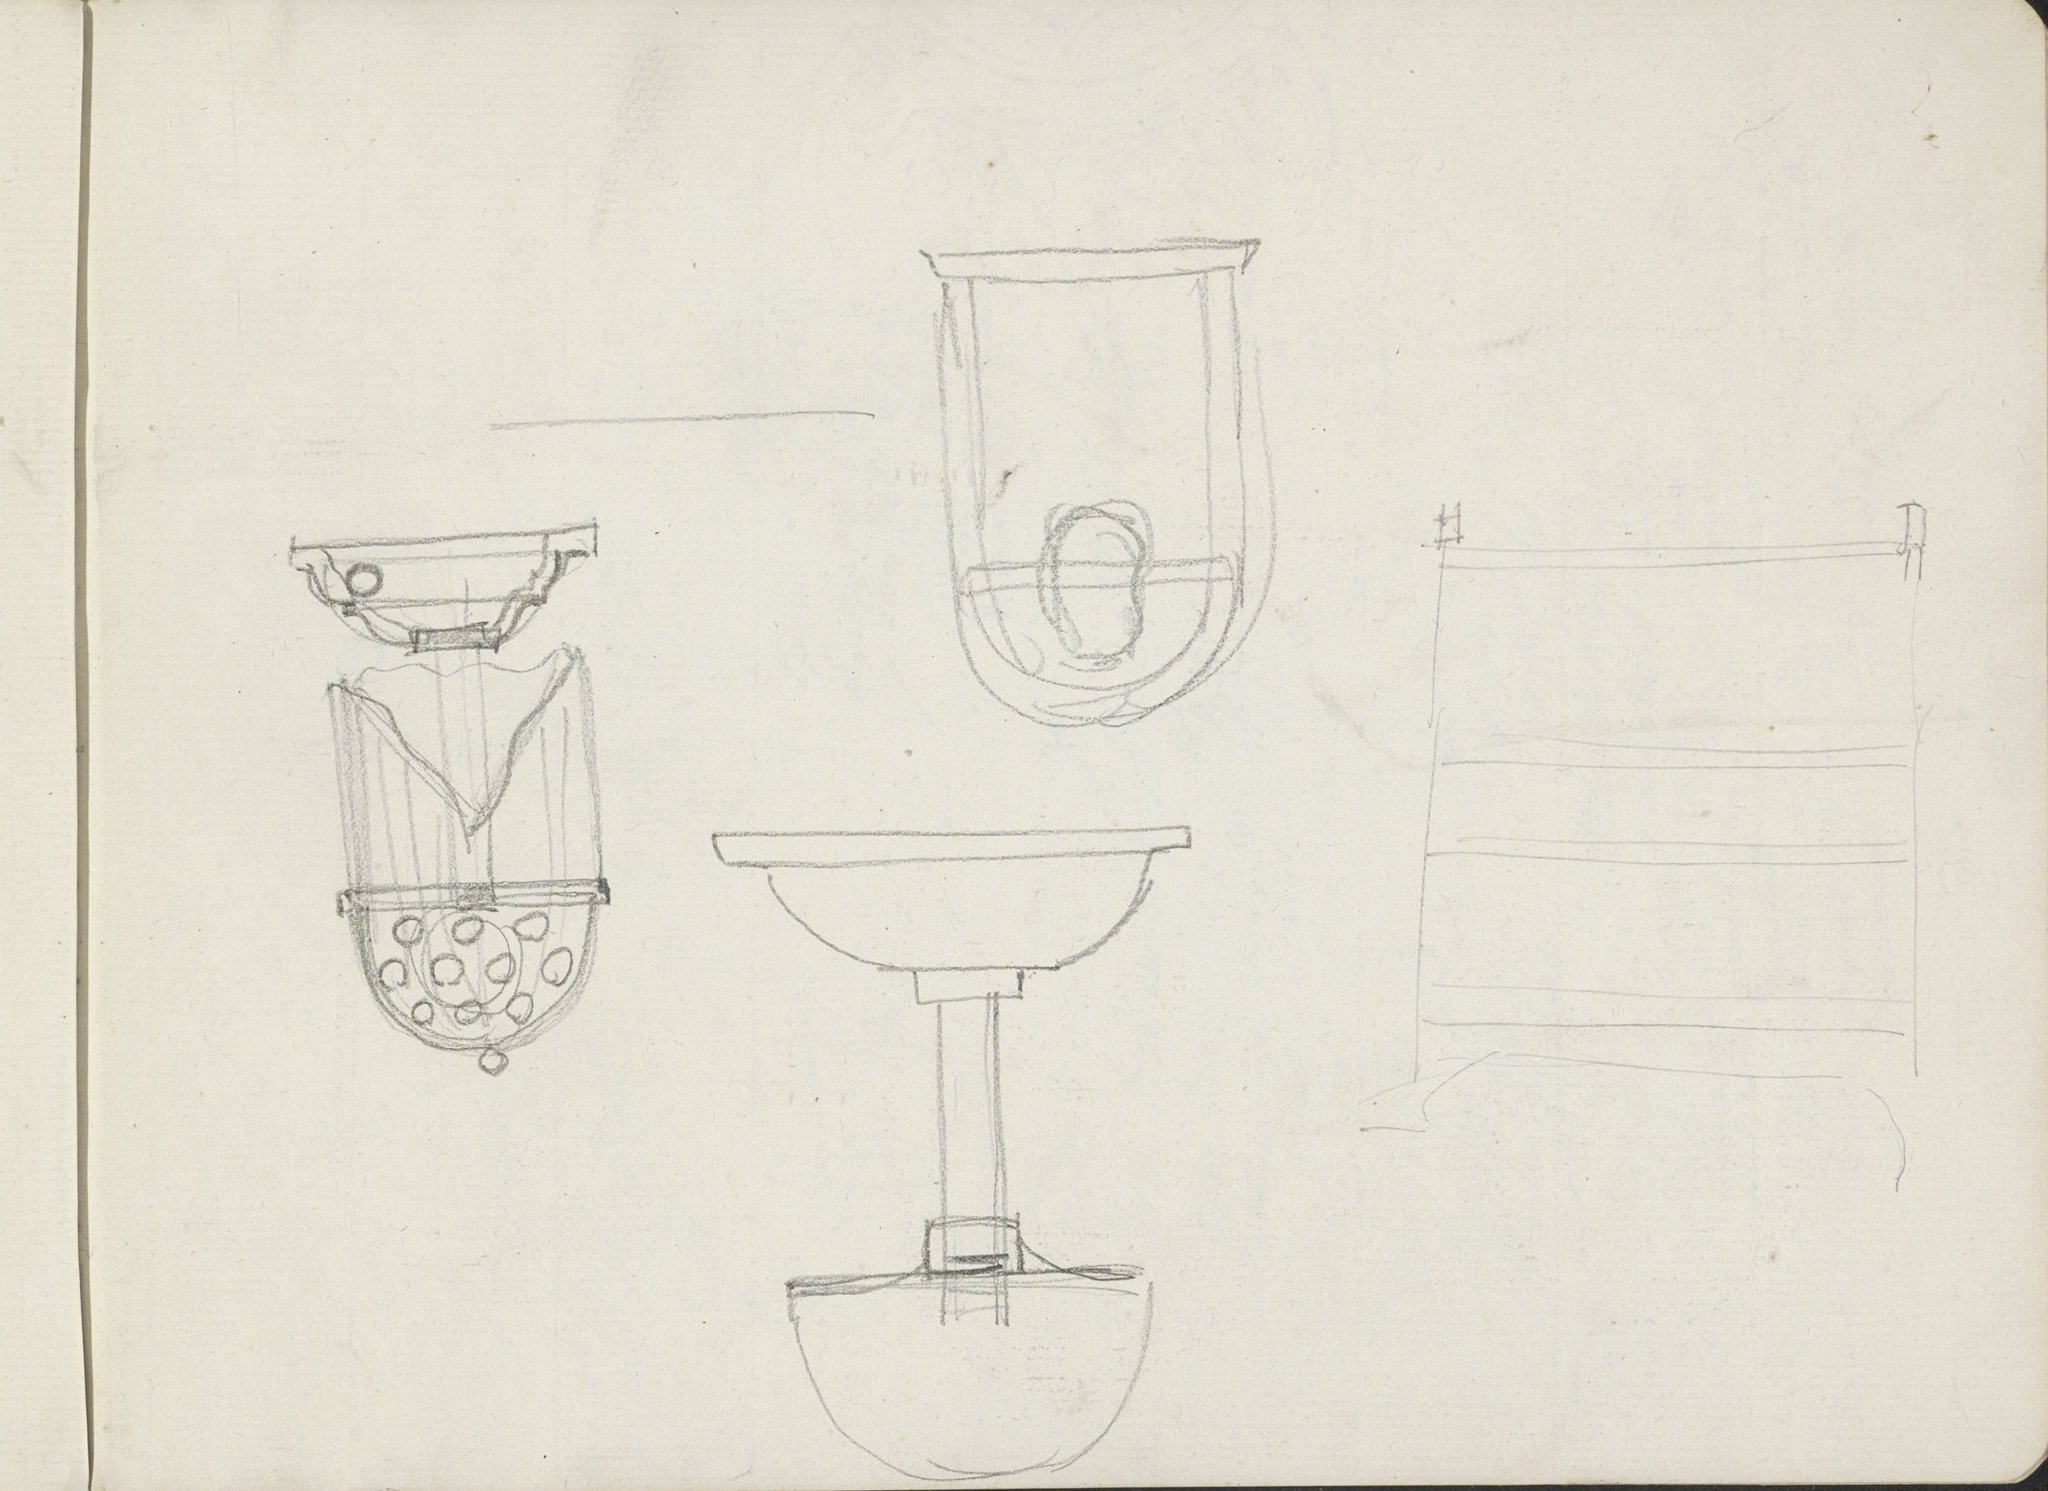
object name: sketchbook leaf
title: Ontwerpen voor lampen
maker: carel adolph lion cachet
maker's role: draughtsman, print maker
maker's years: 1864-1945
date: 1905-1910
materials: paper, pencil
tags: lighting; lamps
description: Blad 27 recto uit een schetsboek met 27 bladen.